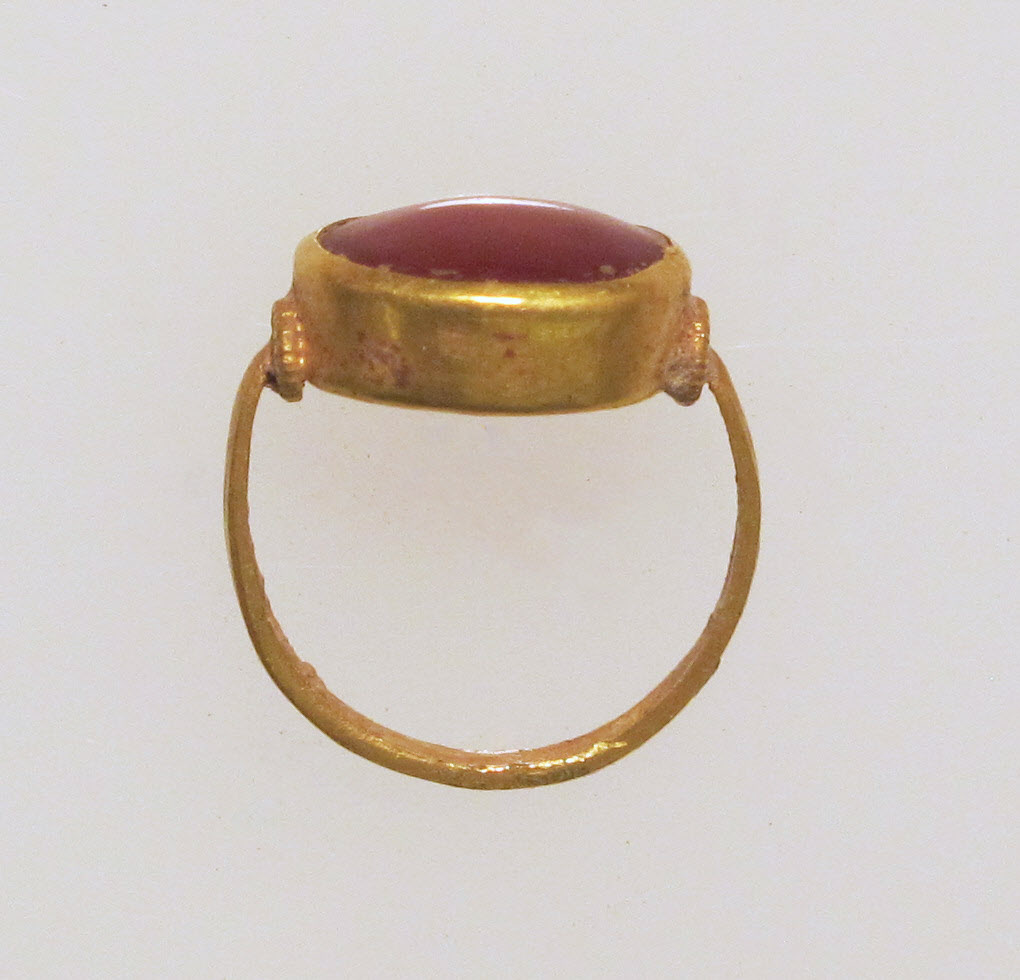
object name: ring, filigree with sard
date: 7000 BCE-330 CE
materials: gold